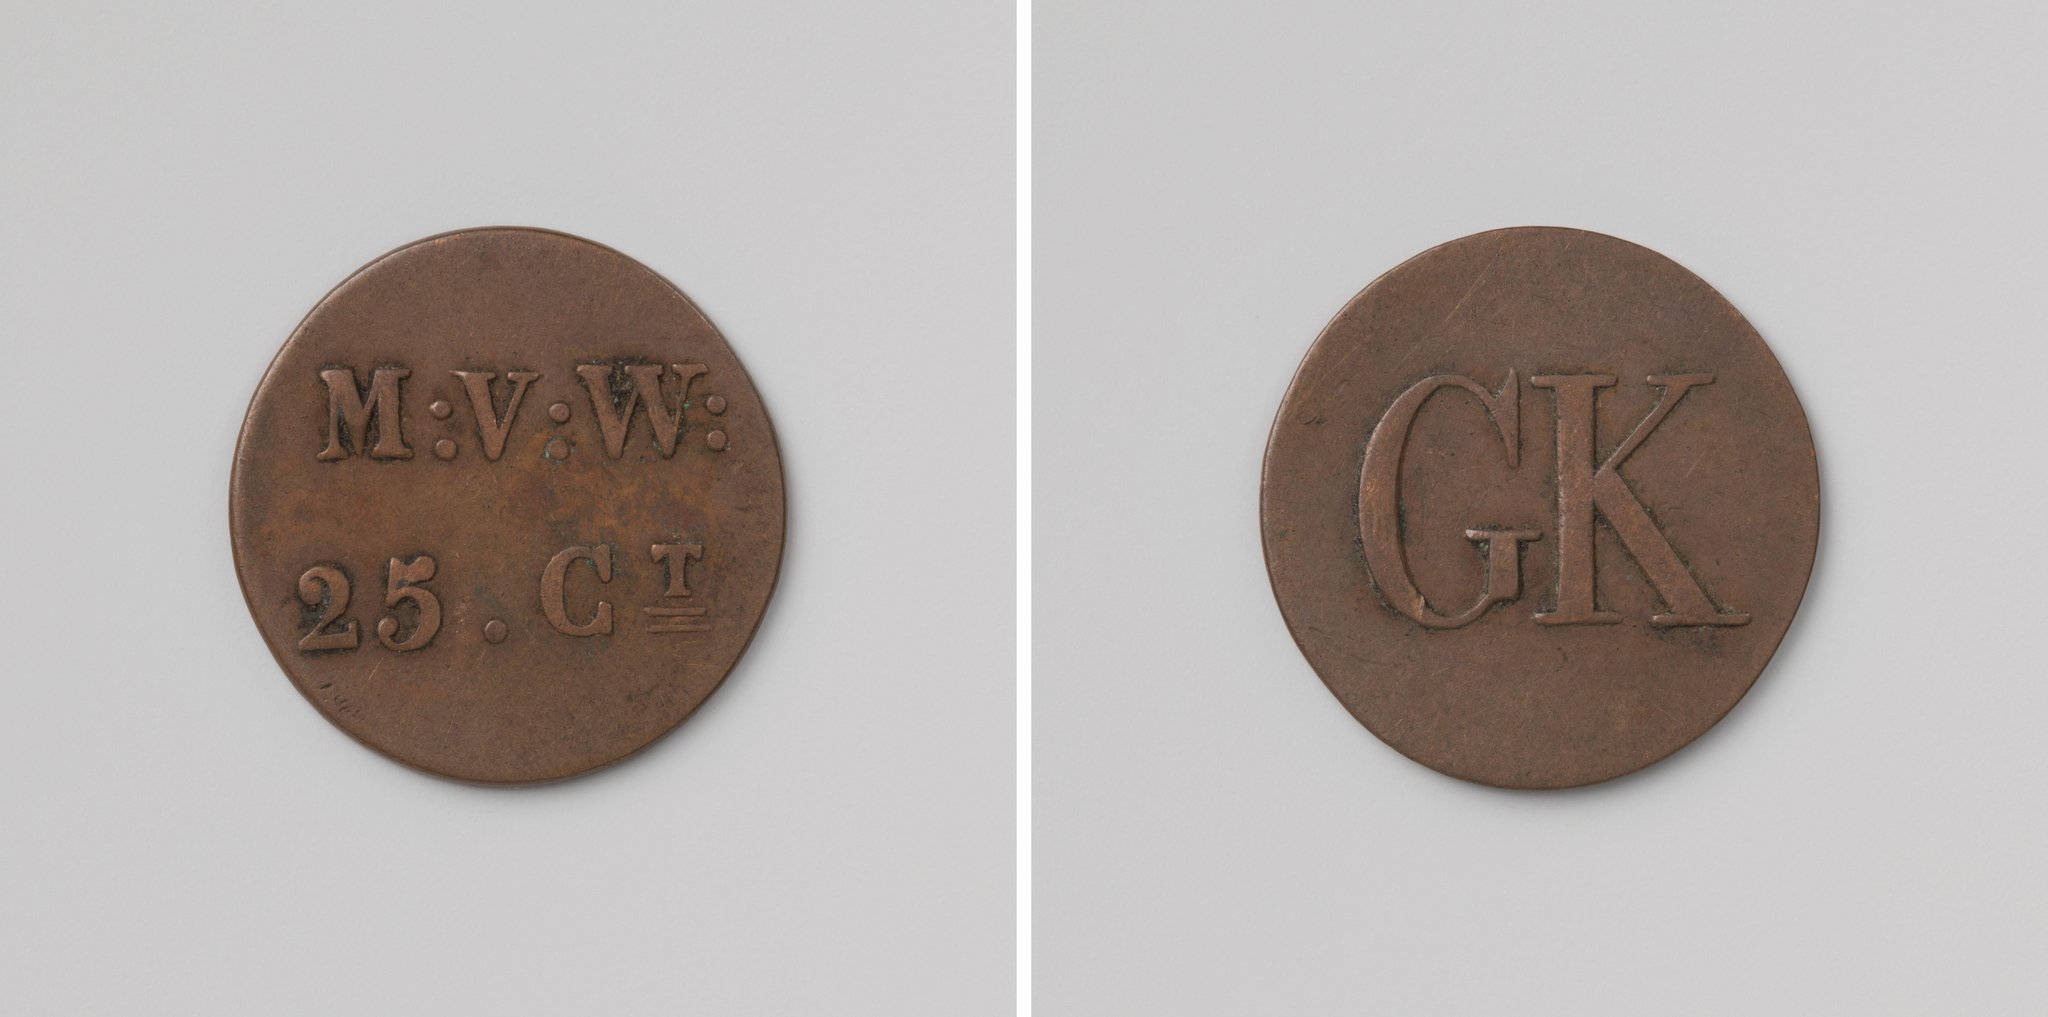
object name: vijfentwintig cent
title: Huismunt geslagen op last van de Maatschappij van Weldadigheid ter waarde van 25 cent, ten behoeve van de Gewone Koloniën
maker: Anonymous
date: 1818-1859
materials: copper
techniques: striking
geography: netherlands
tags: maatschappij van weldadigheid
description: Voorzijde: opschrift boven waardeaanduiding. Keerzijde: opschrift G en K